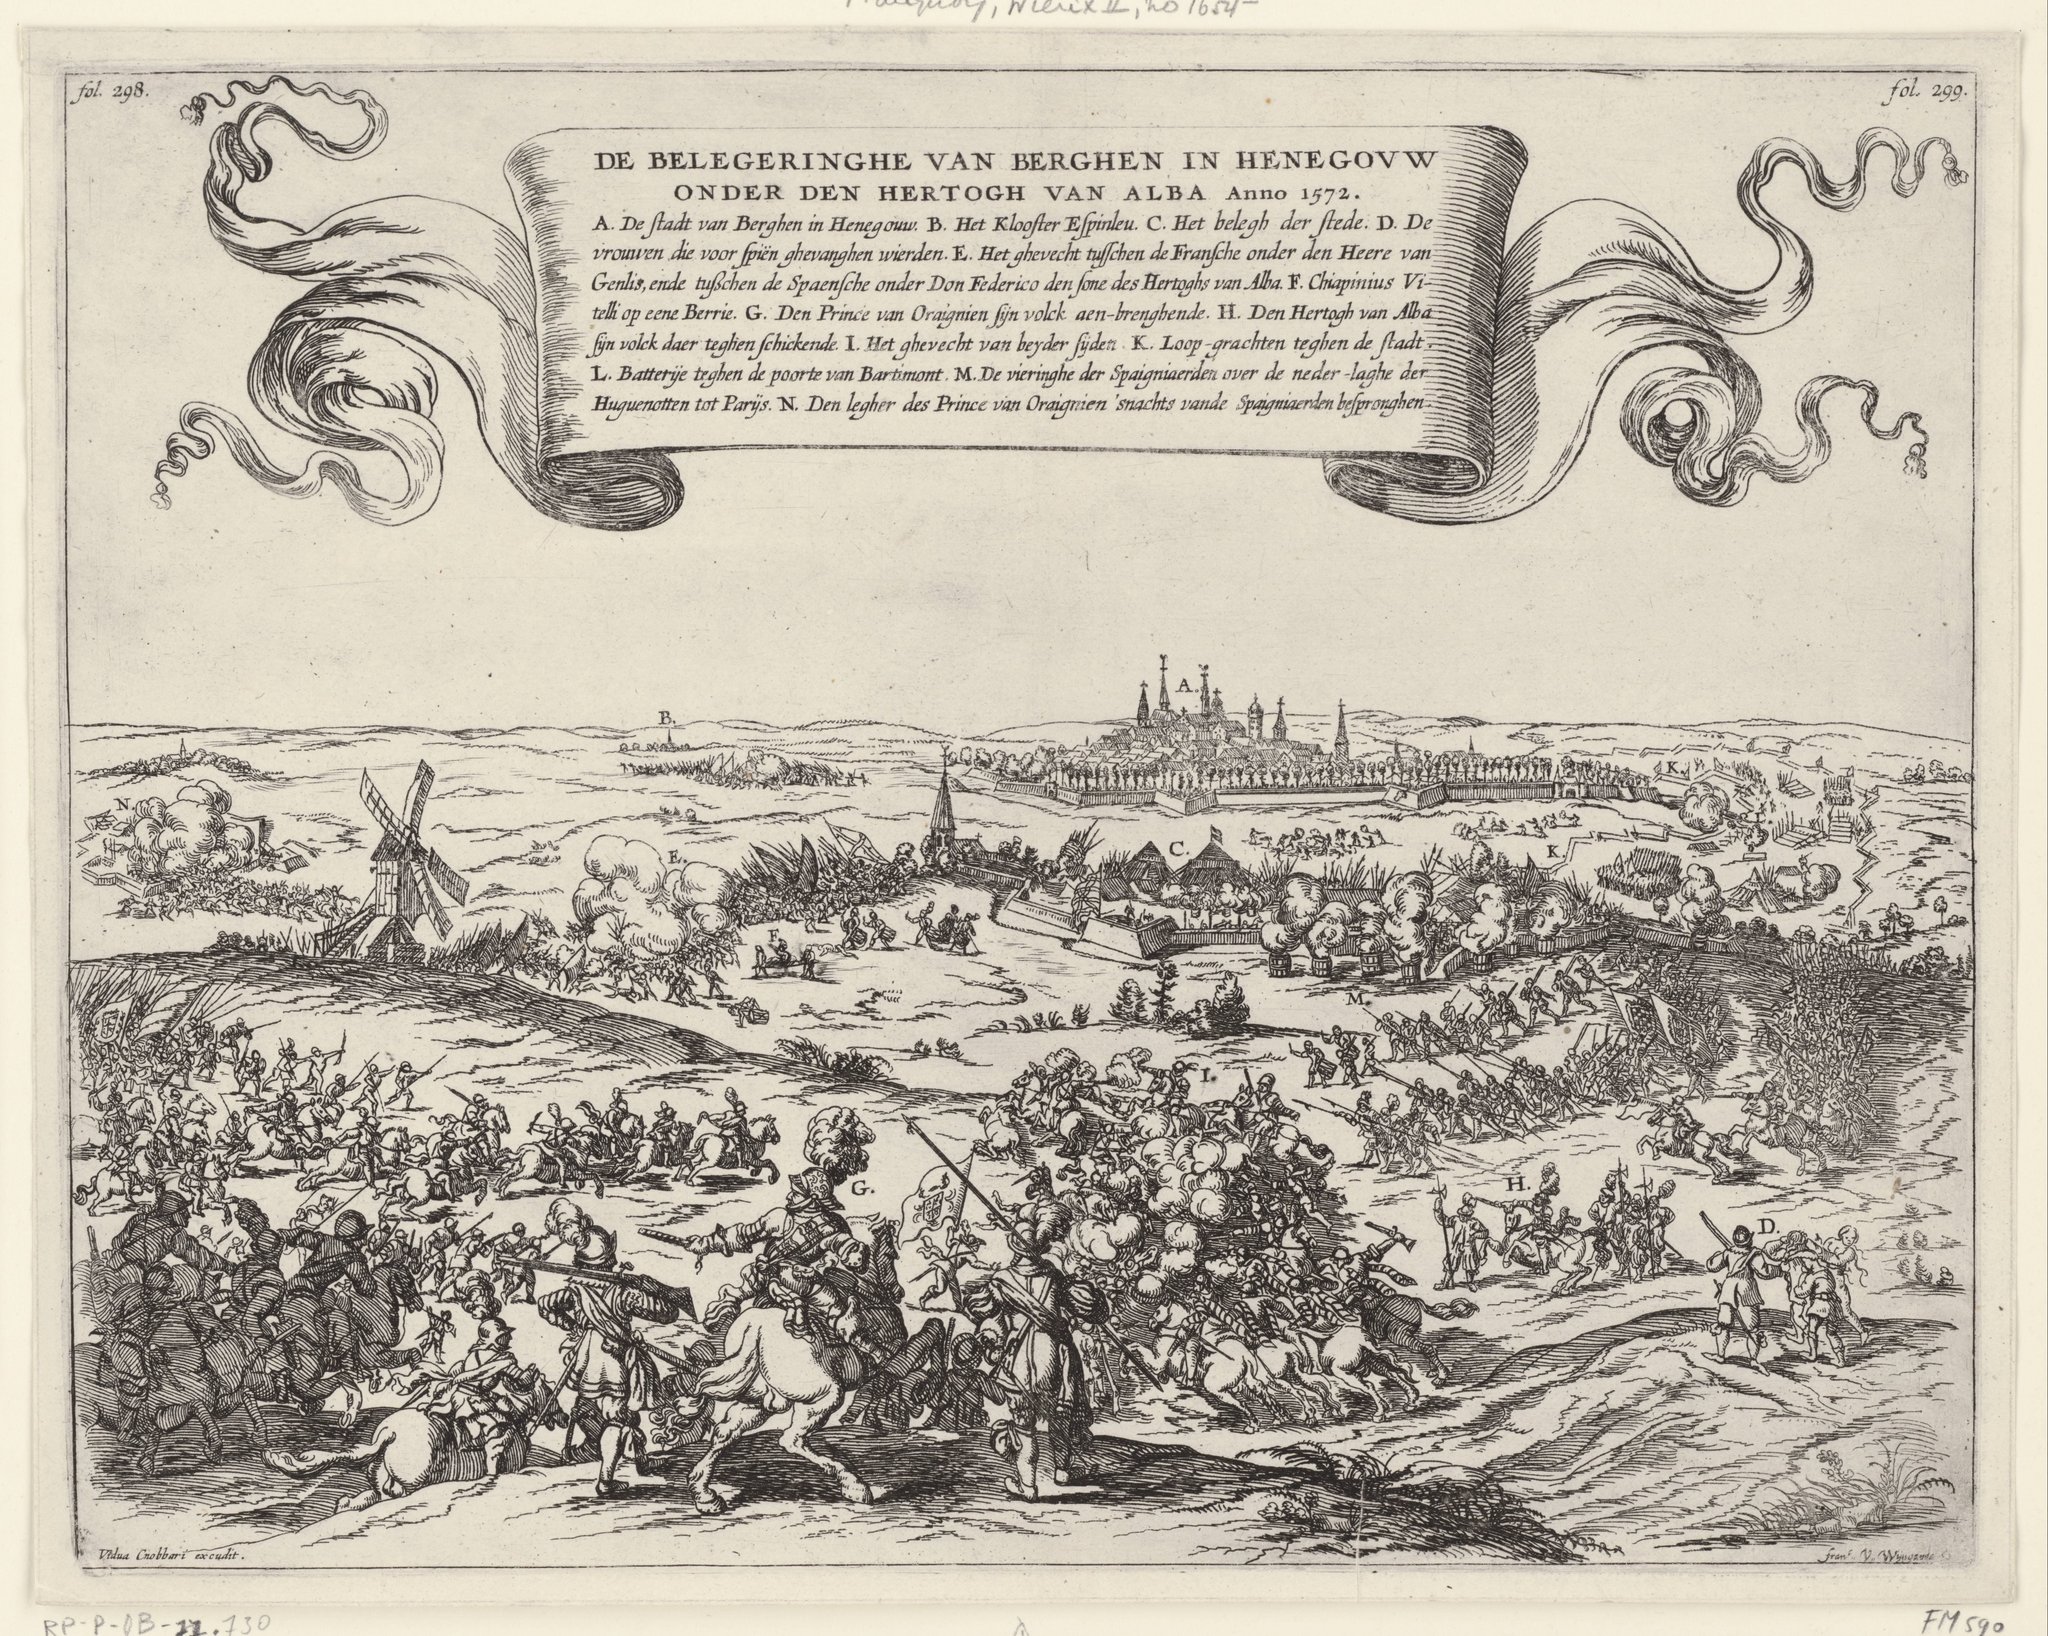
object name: history print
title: De belegeringhe van Berghen in Henegouw onder den hertogh van Alba. Anno 1572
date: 1643-1645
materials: paper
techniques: etching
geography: germany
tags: delft, william i (prince of orange), fernando álvarez de toledo (3rd duke of alba), siege, position war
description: Bergen in Henegouwen door graaf Lodewijk van Nassau met list gewonnen, wordt door Alva belegerd, 18 augustus 1572. Op de voorgrond het leger van de prins van Oranje in een poging om de stad te ontzetten, rechts het leger van Alva. Bovenin een banderol met de titel en legenda A-N in het Nederlands.